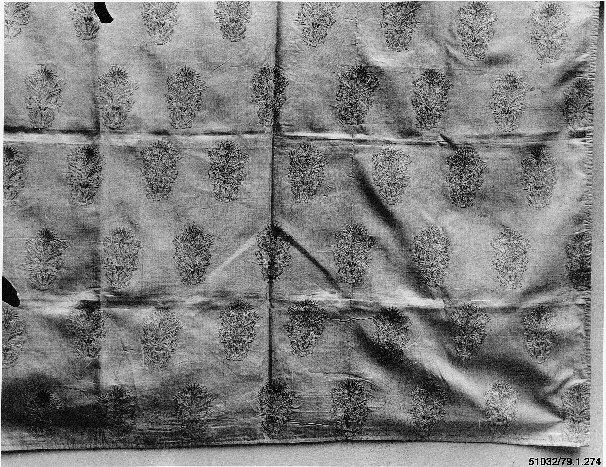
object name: cover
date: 1767-1800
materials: metal thread, silk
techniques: embroidery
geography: turkey